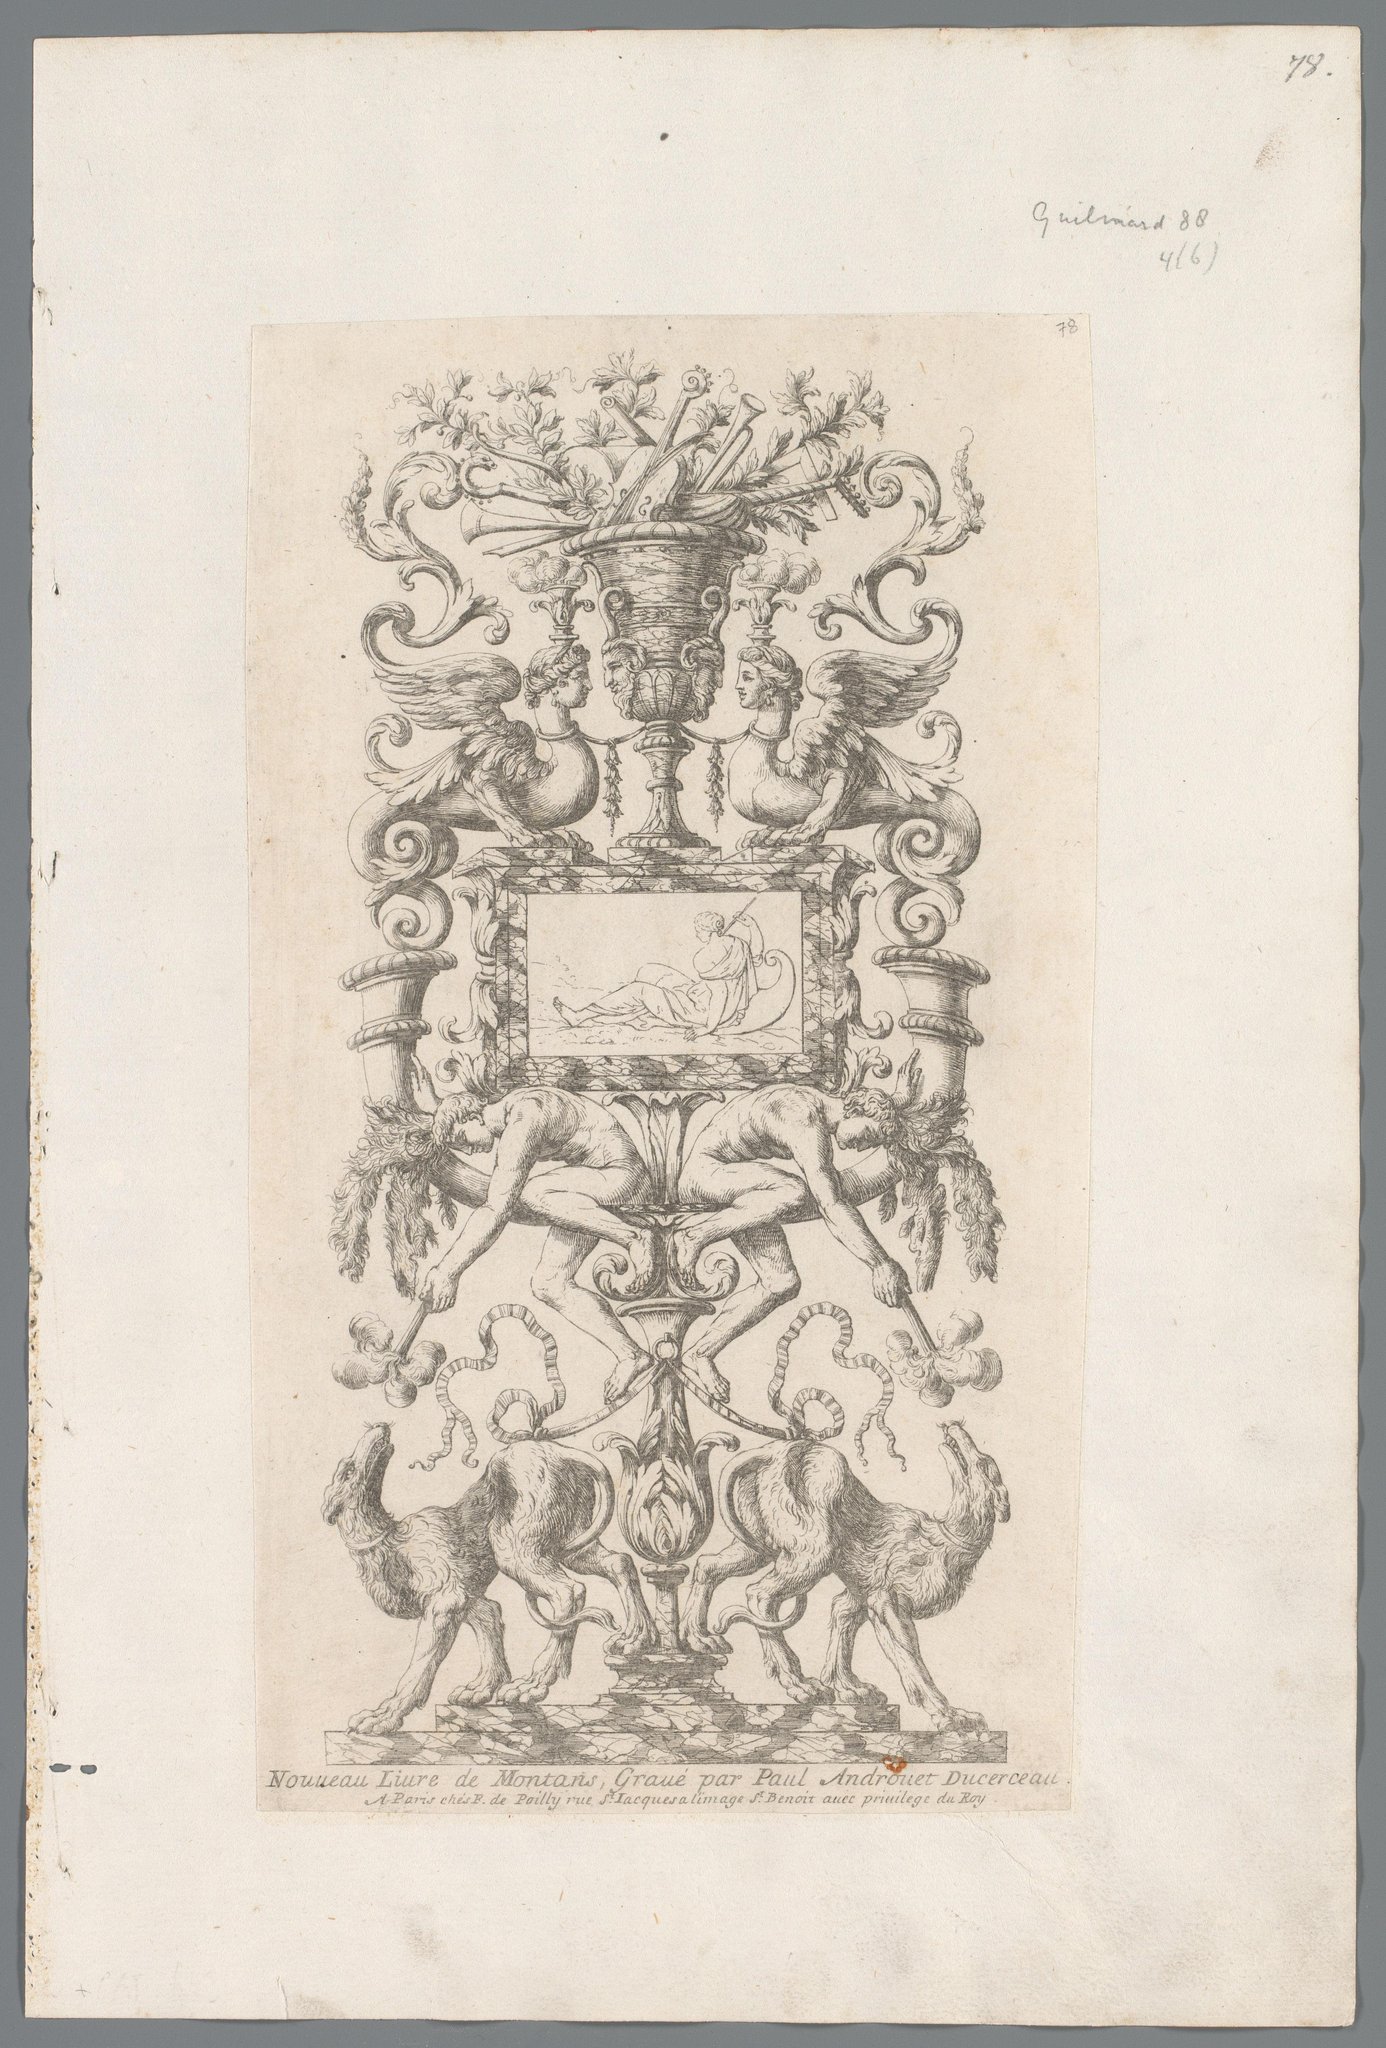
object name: ornament print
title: Ontwerpen voor decoratieve panelen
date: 1670-1693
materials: paper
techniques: etching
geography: paris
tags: musical instruments; group of musical instruments, ornament ~ candelabrum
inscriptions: collector's mark: Lugt 2760, collector's mark: Lugt 2228